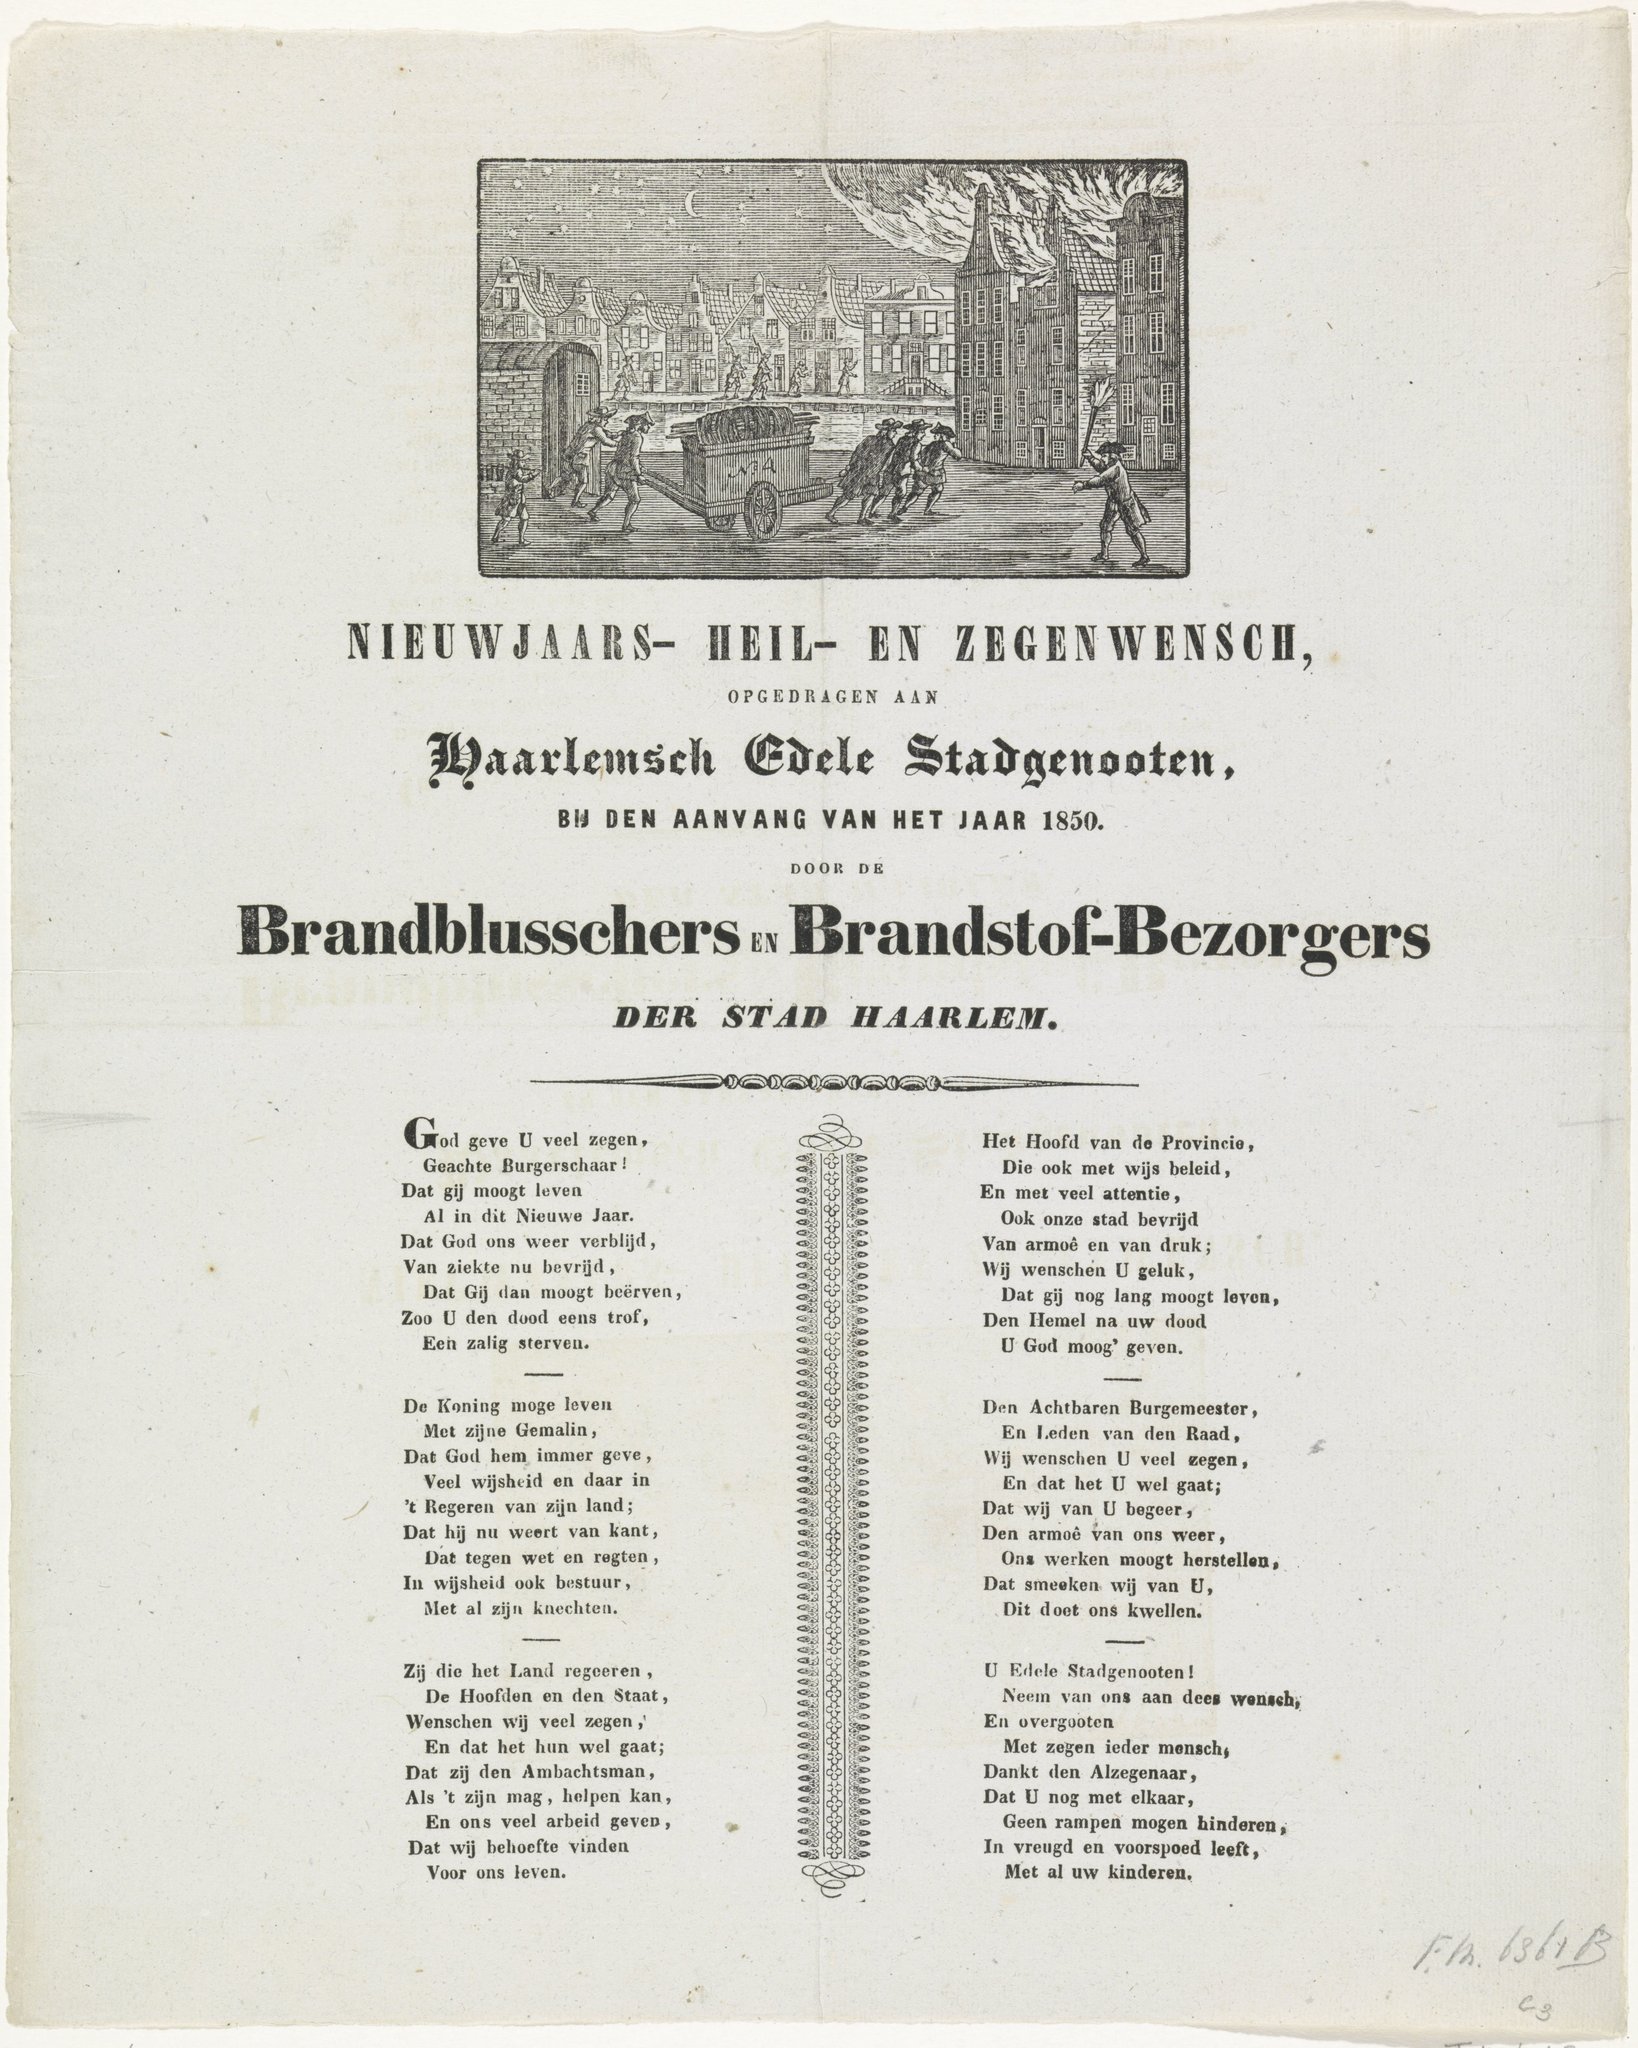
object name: print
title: Nieuwjaars-, Heil- en Zegenwensch (...) 1850. Door de Brandblusschers en Brandstof-Bezorgers der Stad Haarlem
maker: Anonymous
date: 1849-1850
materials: paper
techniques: letterpress printing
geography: haarlem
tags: fire-department, fire-brigade, street, haarlem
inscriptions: collector's mark: Lugt 2228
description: Nieuwjaarswens van de Haarlemse brandblussers en brandstofbezorger voor het jaar 1850. De brandweer rukt uit met een brandspuit om een brand in enkele panden aan een gracht te blussen. Met een vers in twee kolommen.